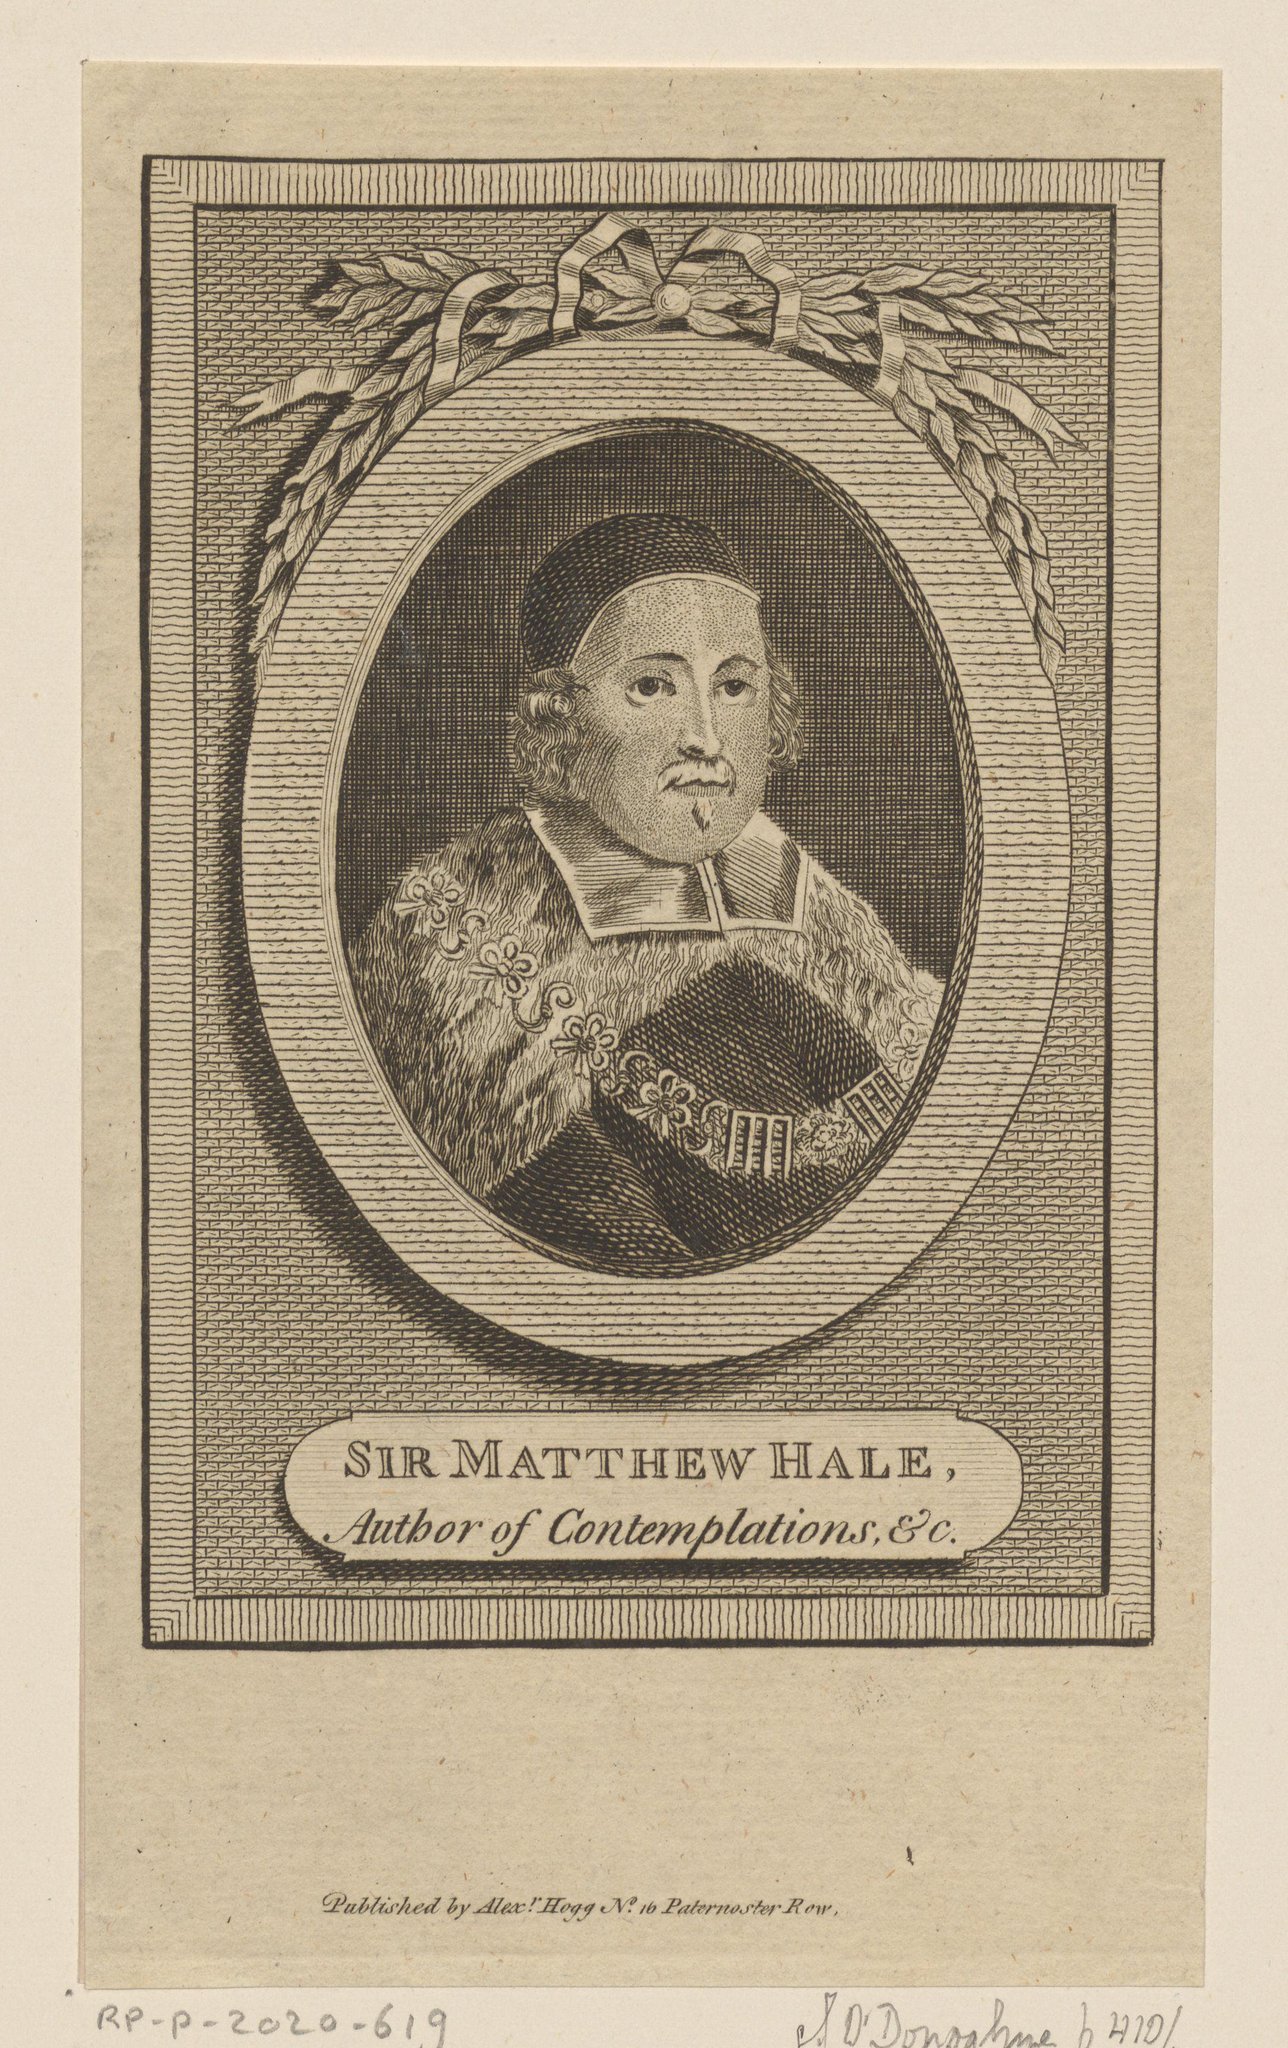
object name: print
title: Portret van Matthew Hale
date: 1778-1824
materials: paper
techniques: engraving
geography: london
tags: historical persons, barrister